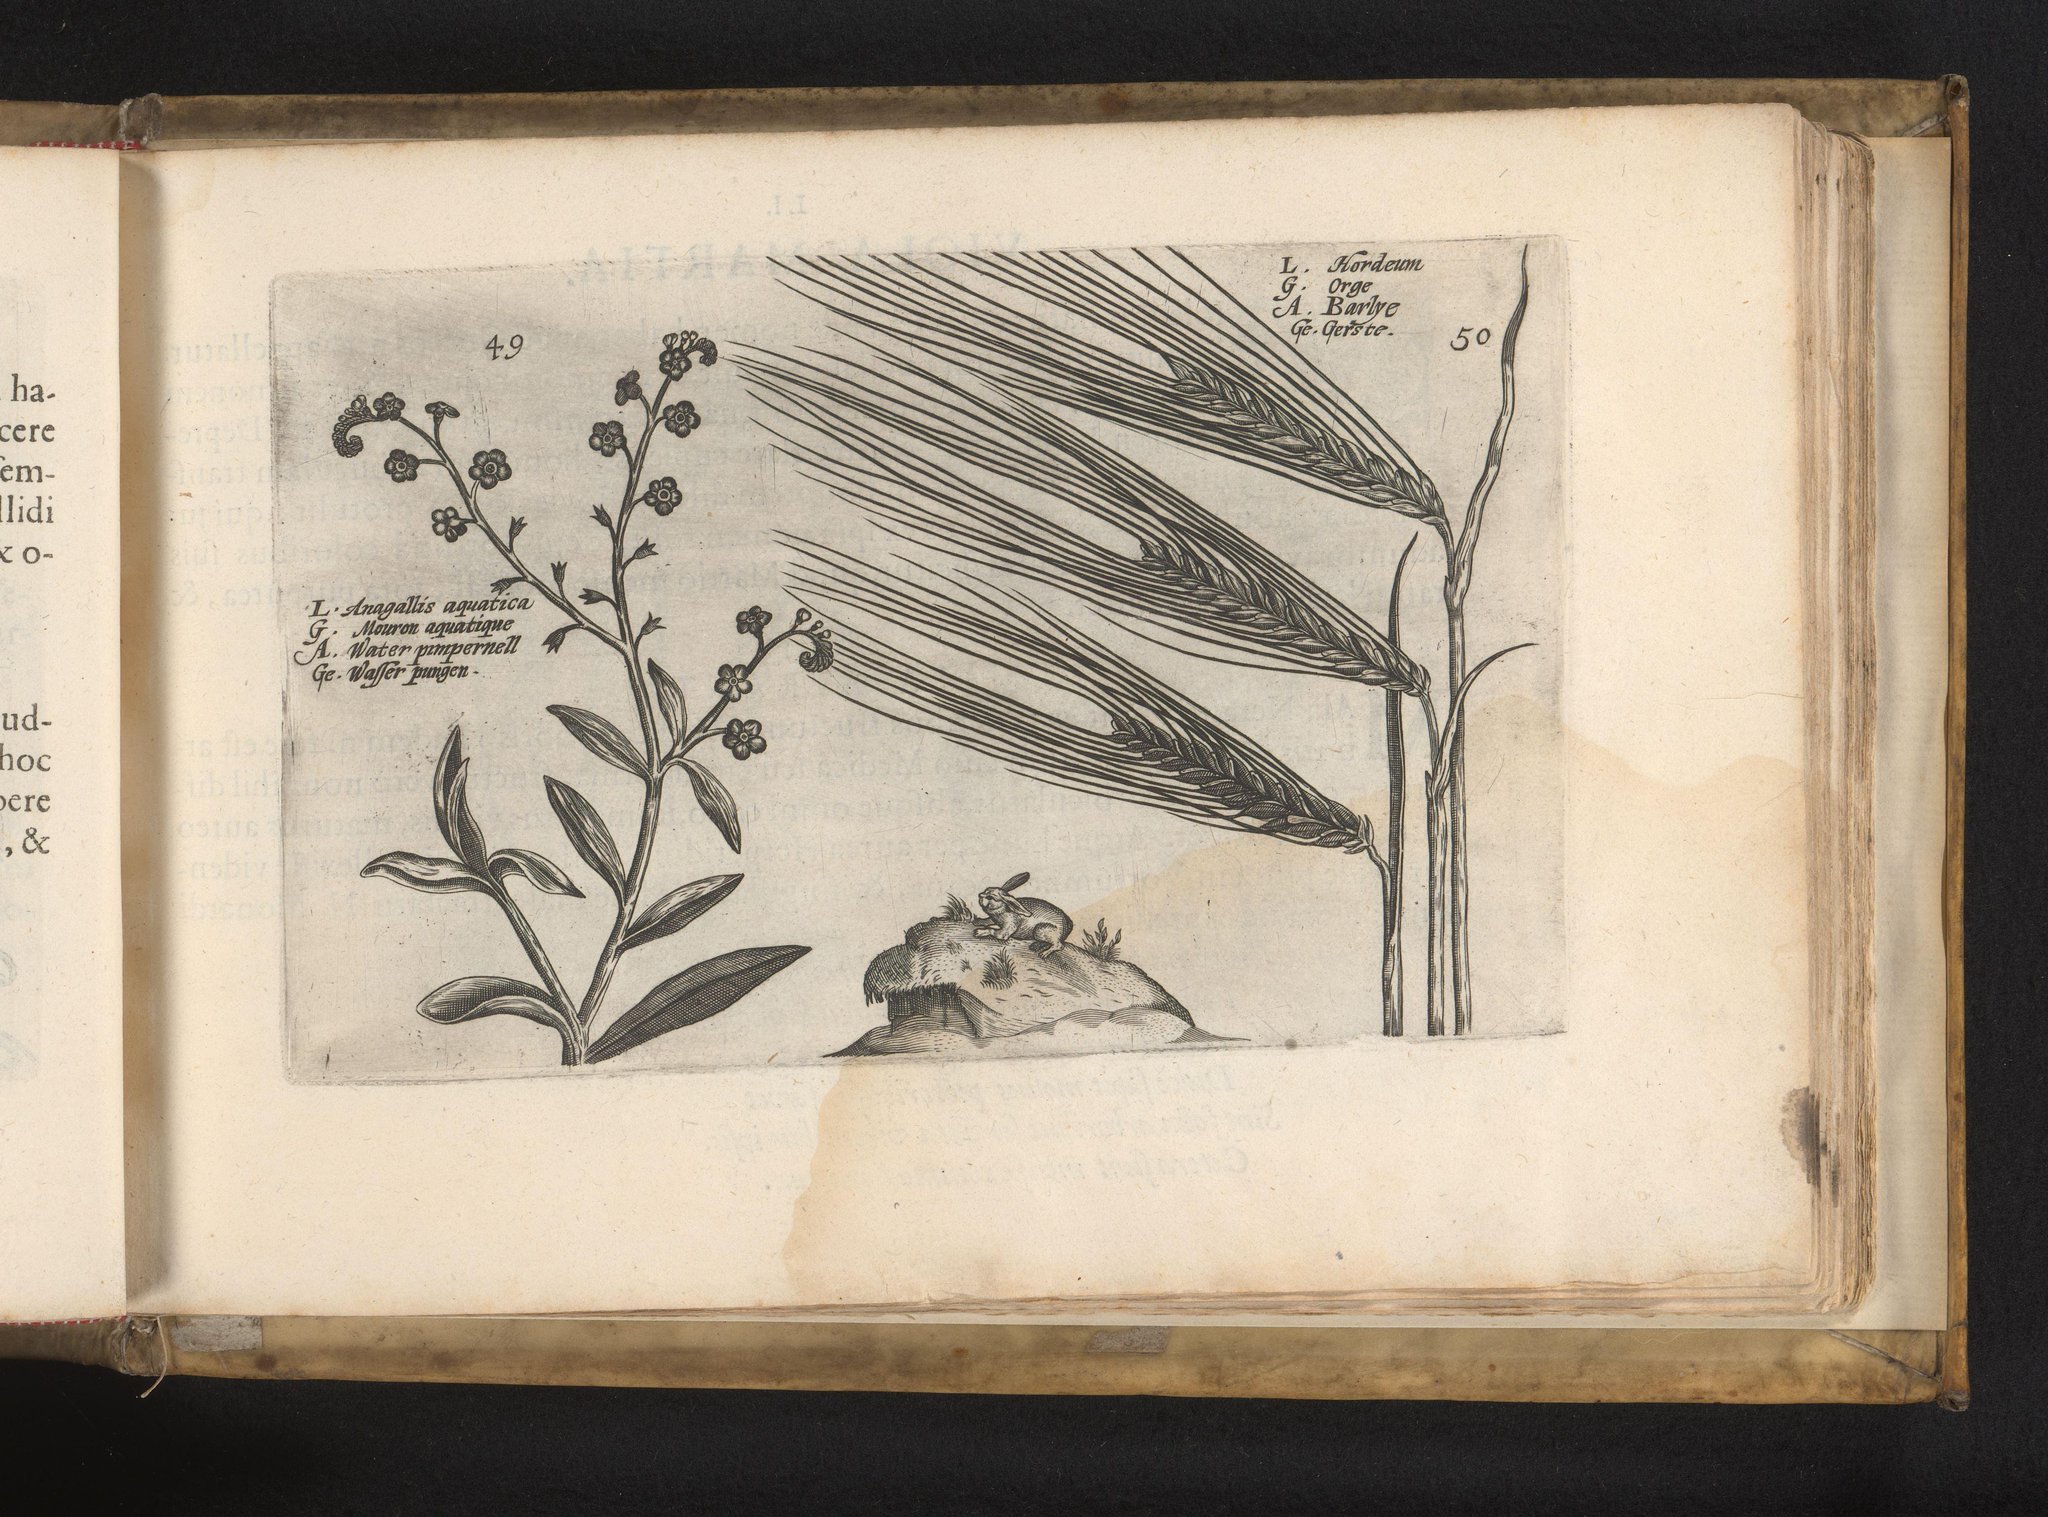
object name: page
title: Hortus floridus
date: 1617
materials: paper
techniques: engraving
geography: arnhem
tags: flowers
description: Prent uit: Passe, Crispijn van de (II). Hortus floridus in quo rariorum & minus vulgarium florum icones ad vivam veramque formam. Arnhem: Johannes Janssonius, 1617.